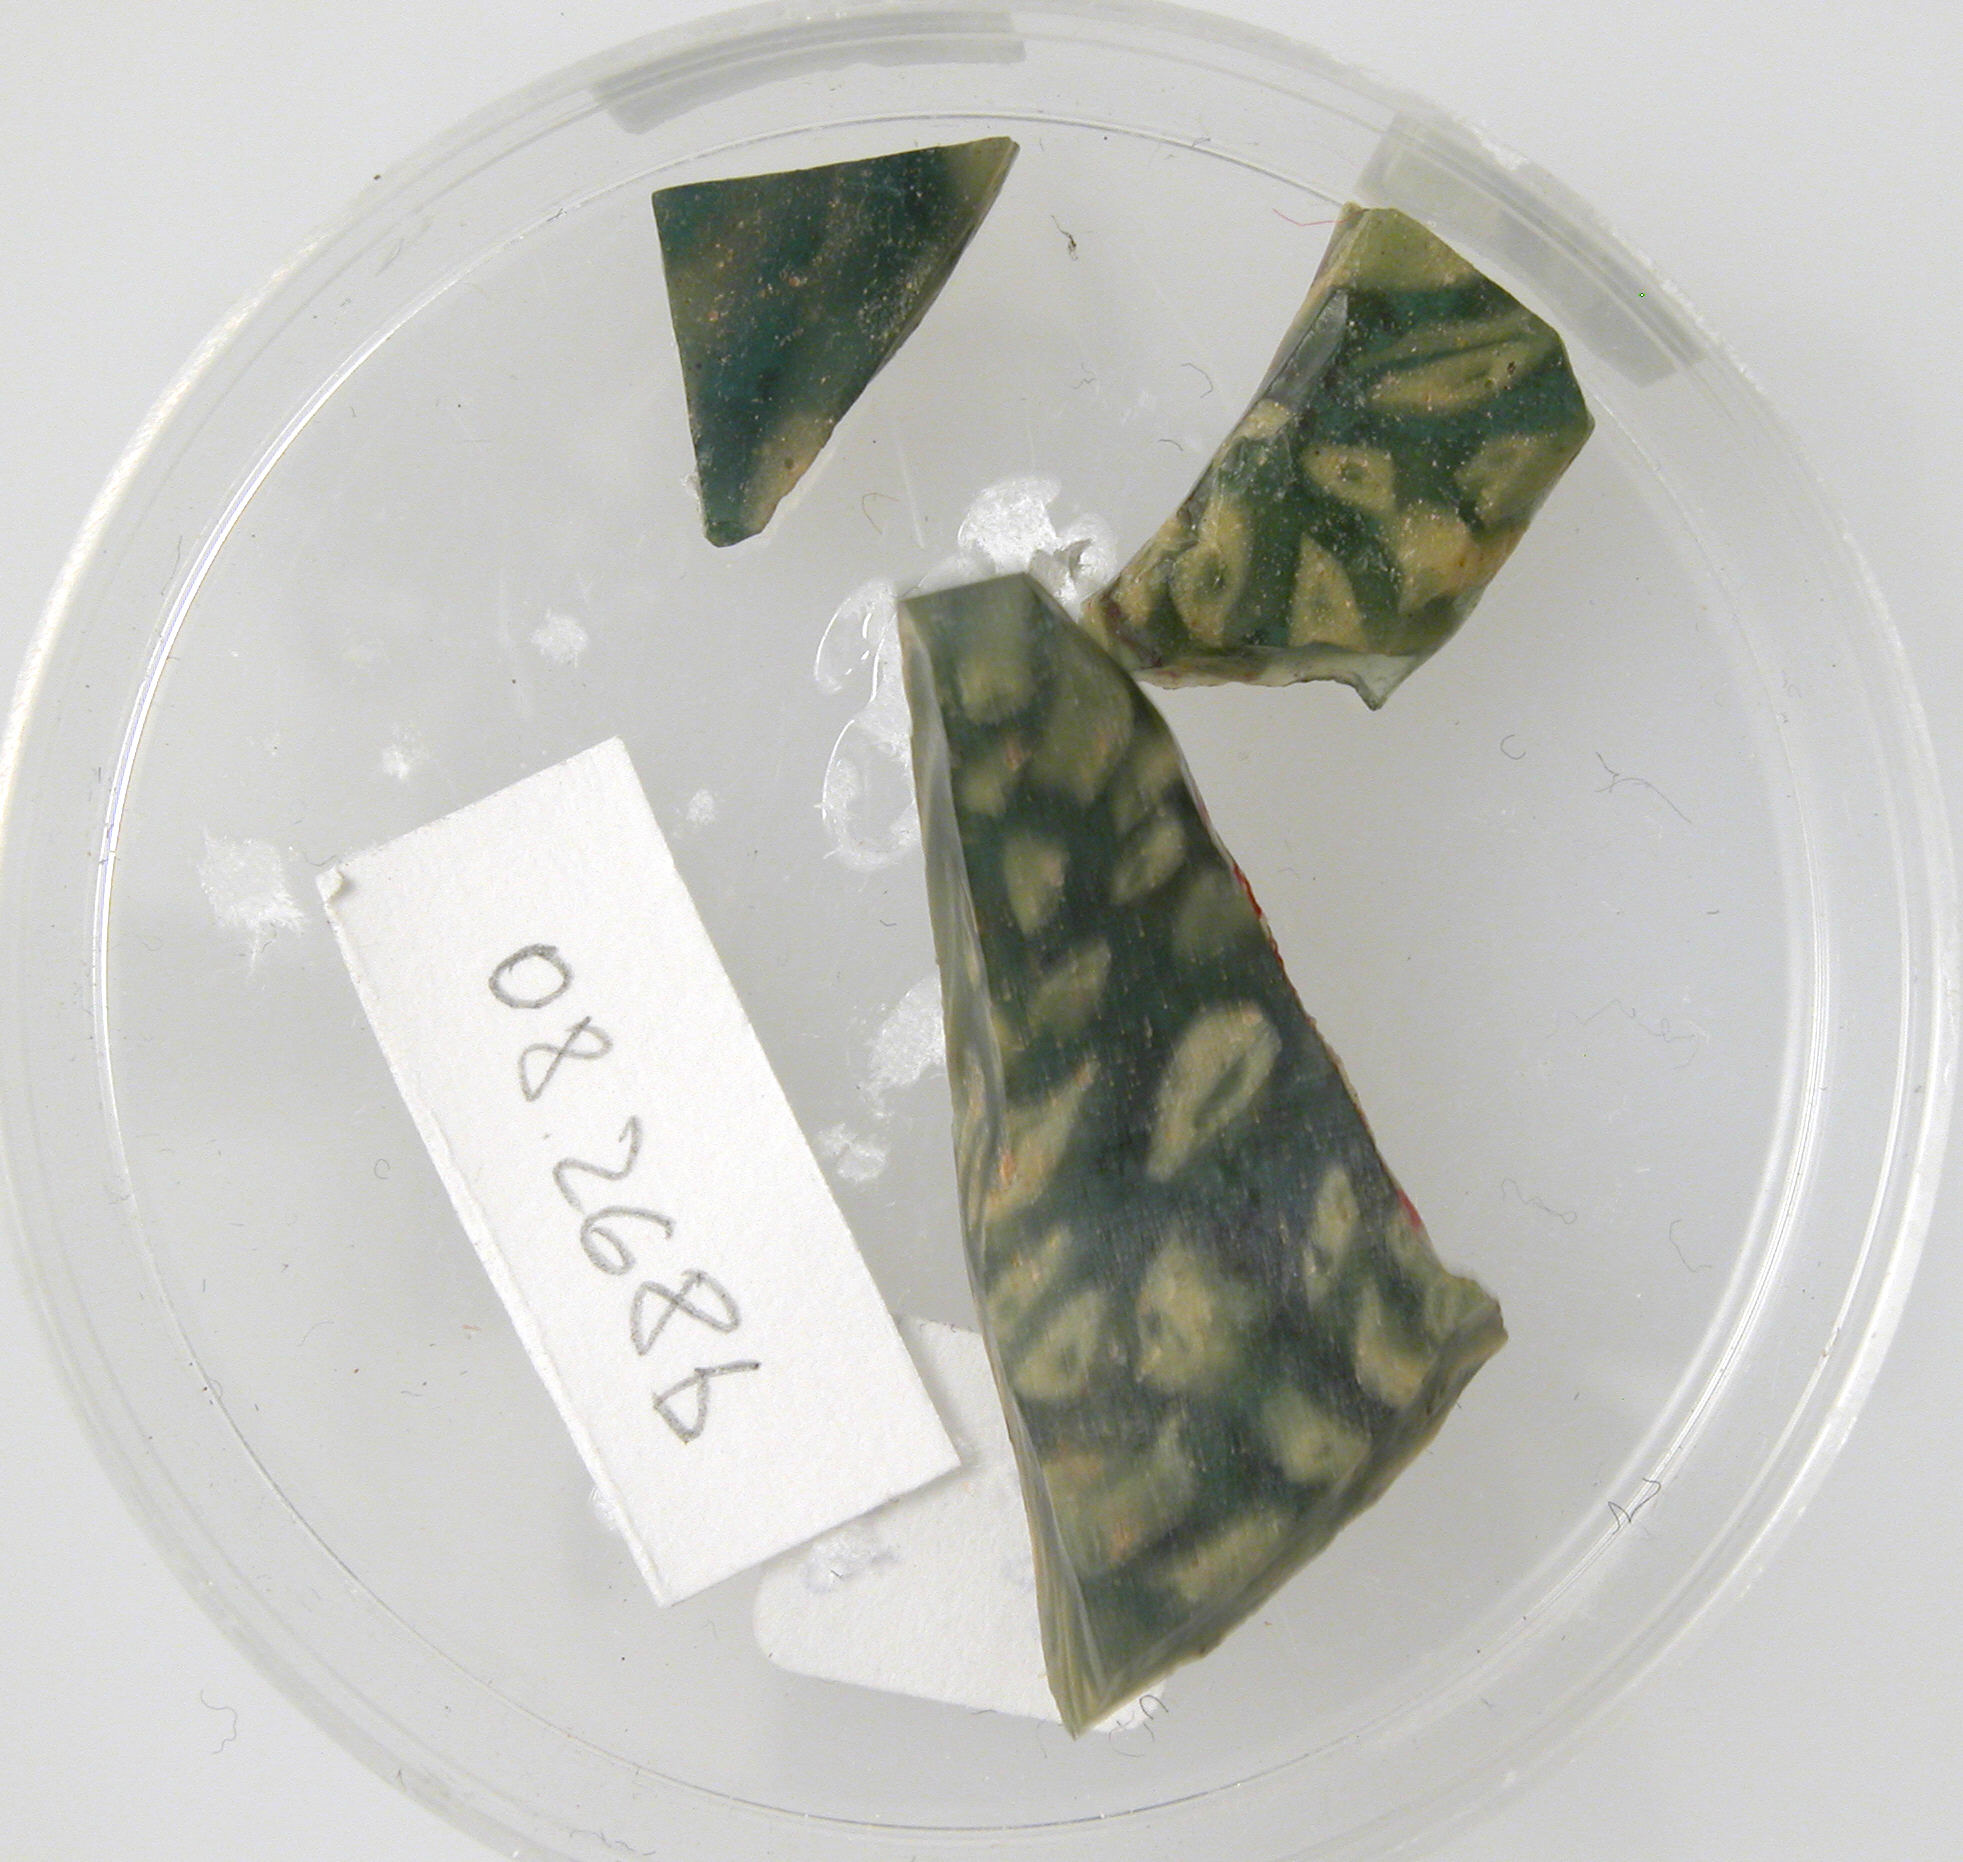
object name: fragment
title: Glass Fragments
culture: coptic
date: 301-433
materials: glass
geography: egypt